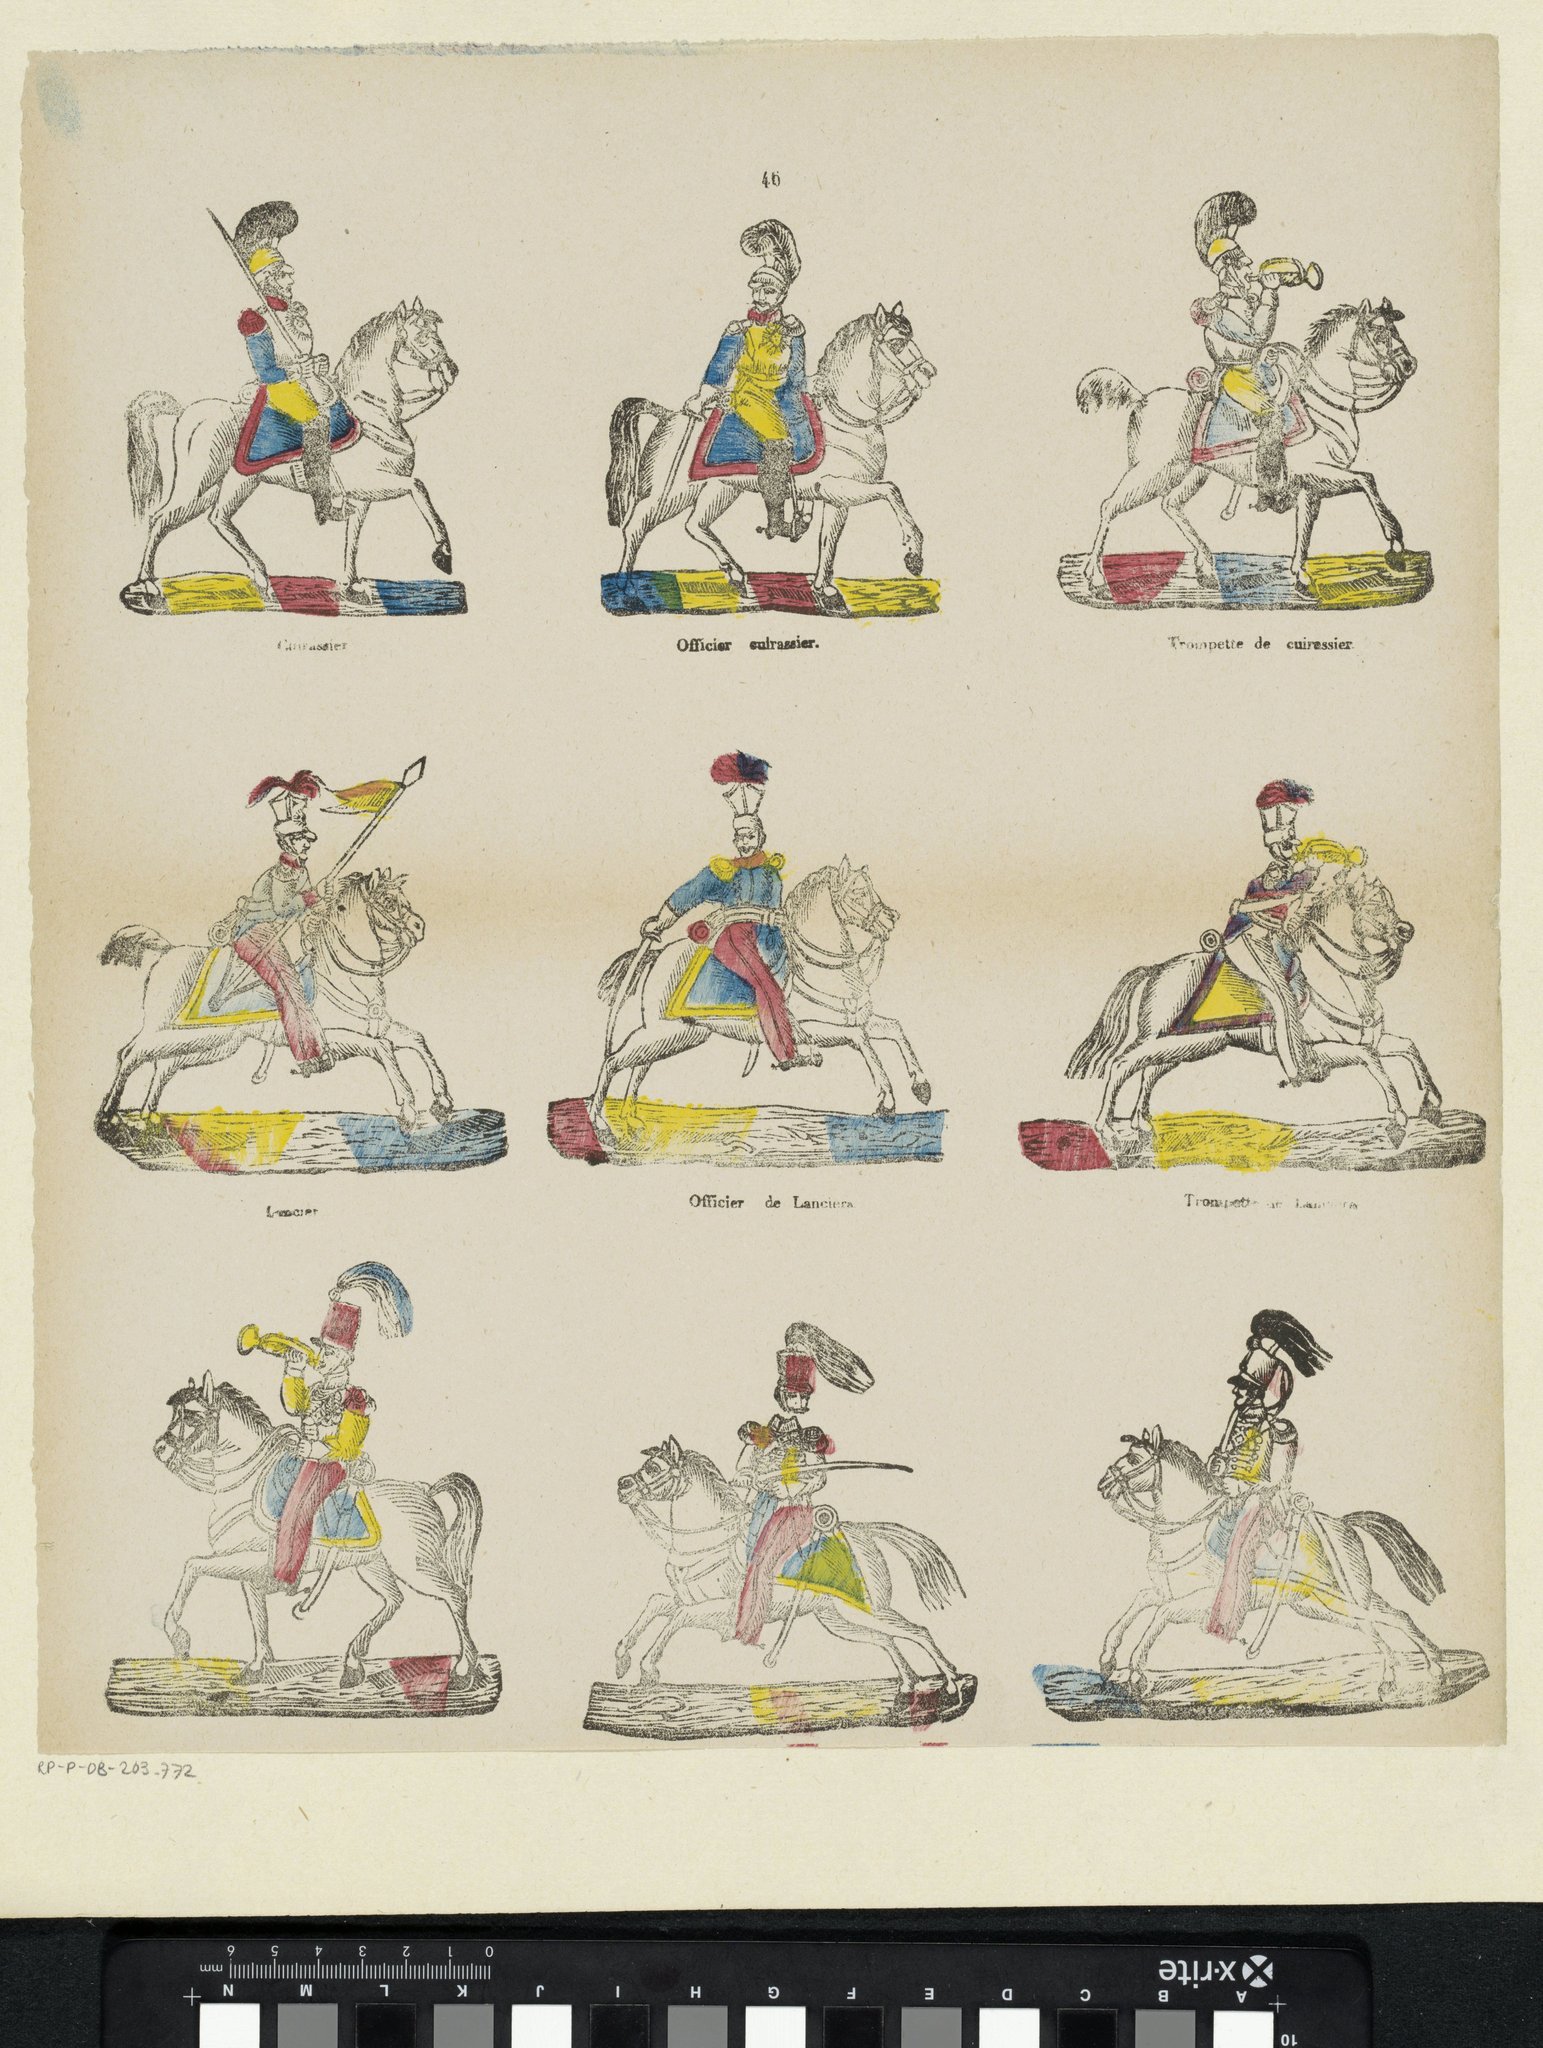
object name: print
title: Militairen te paard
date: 1827-1894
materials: paper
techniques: colour, letterpress printing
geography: schaarbeek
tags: warfare; military affairs (+ cavalry, horsemen), the soldier; the soldier's life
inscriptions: collector's mark: Lugt 2760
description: Blad met 9 voorstellingen van militairen te paard. Onder enkele afbeeldingen een onderschrift in het Frans. Genummerd midden boven: 46.